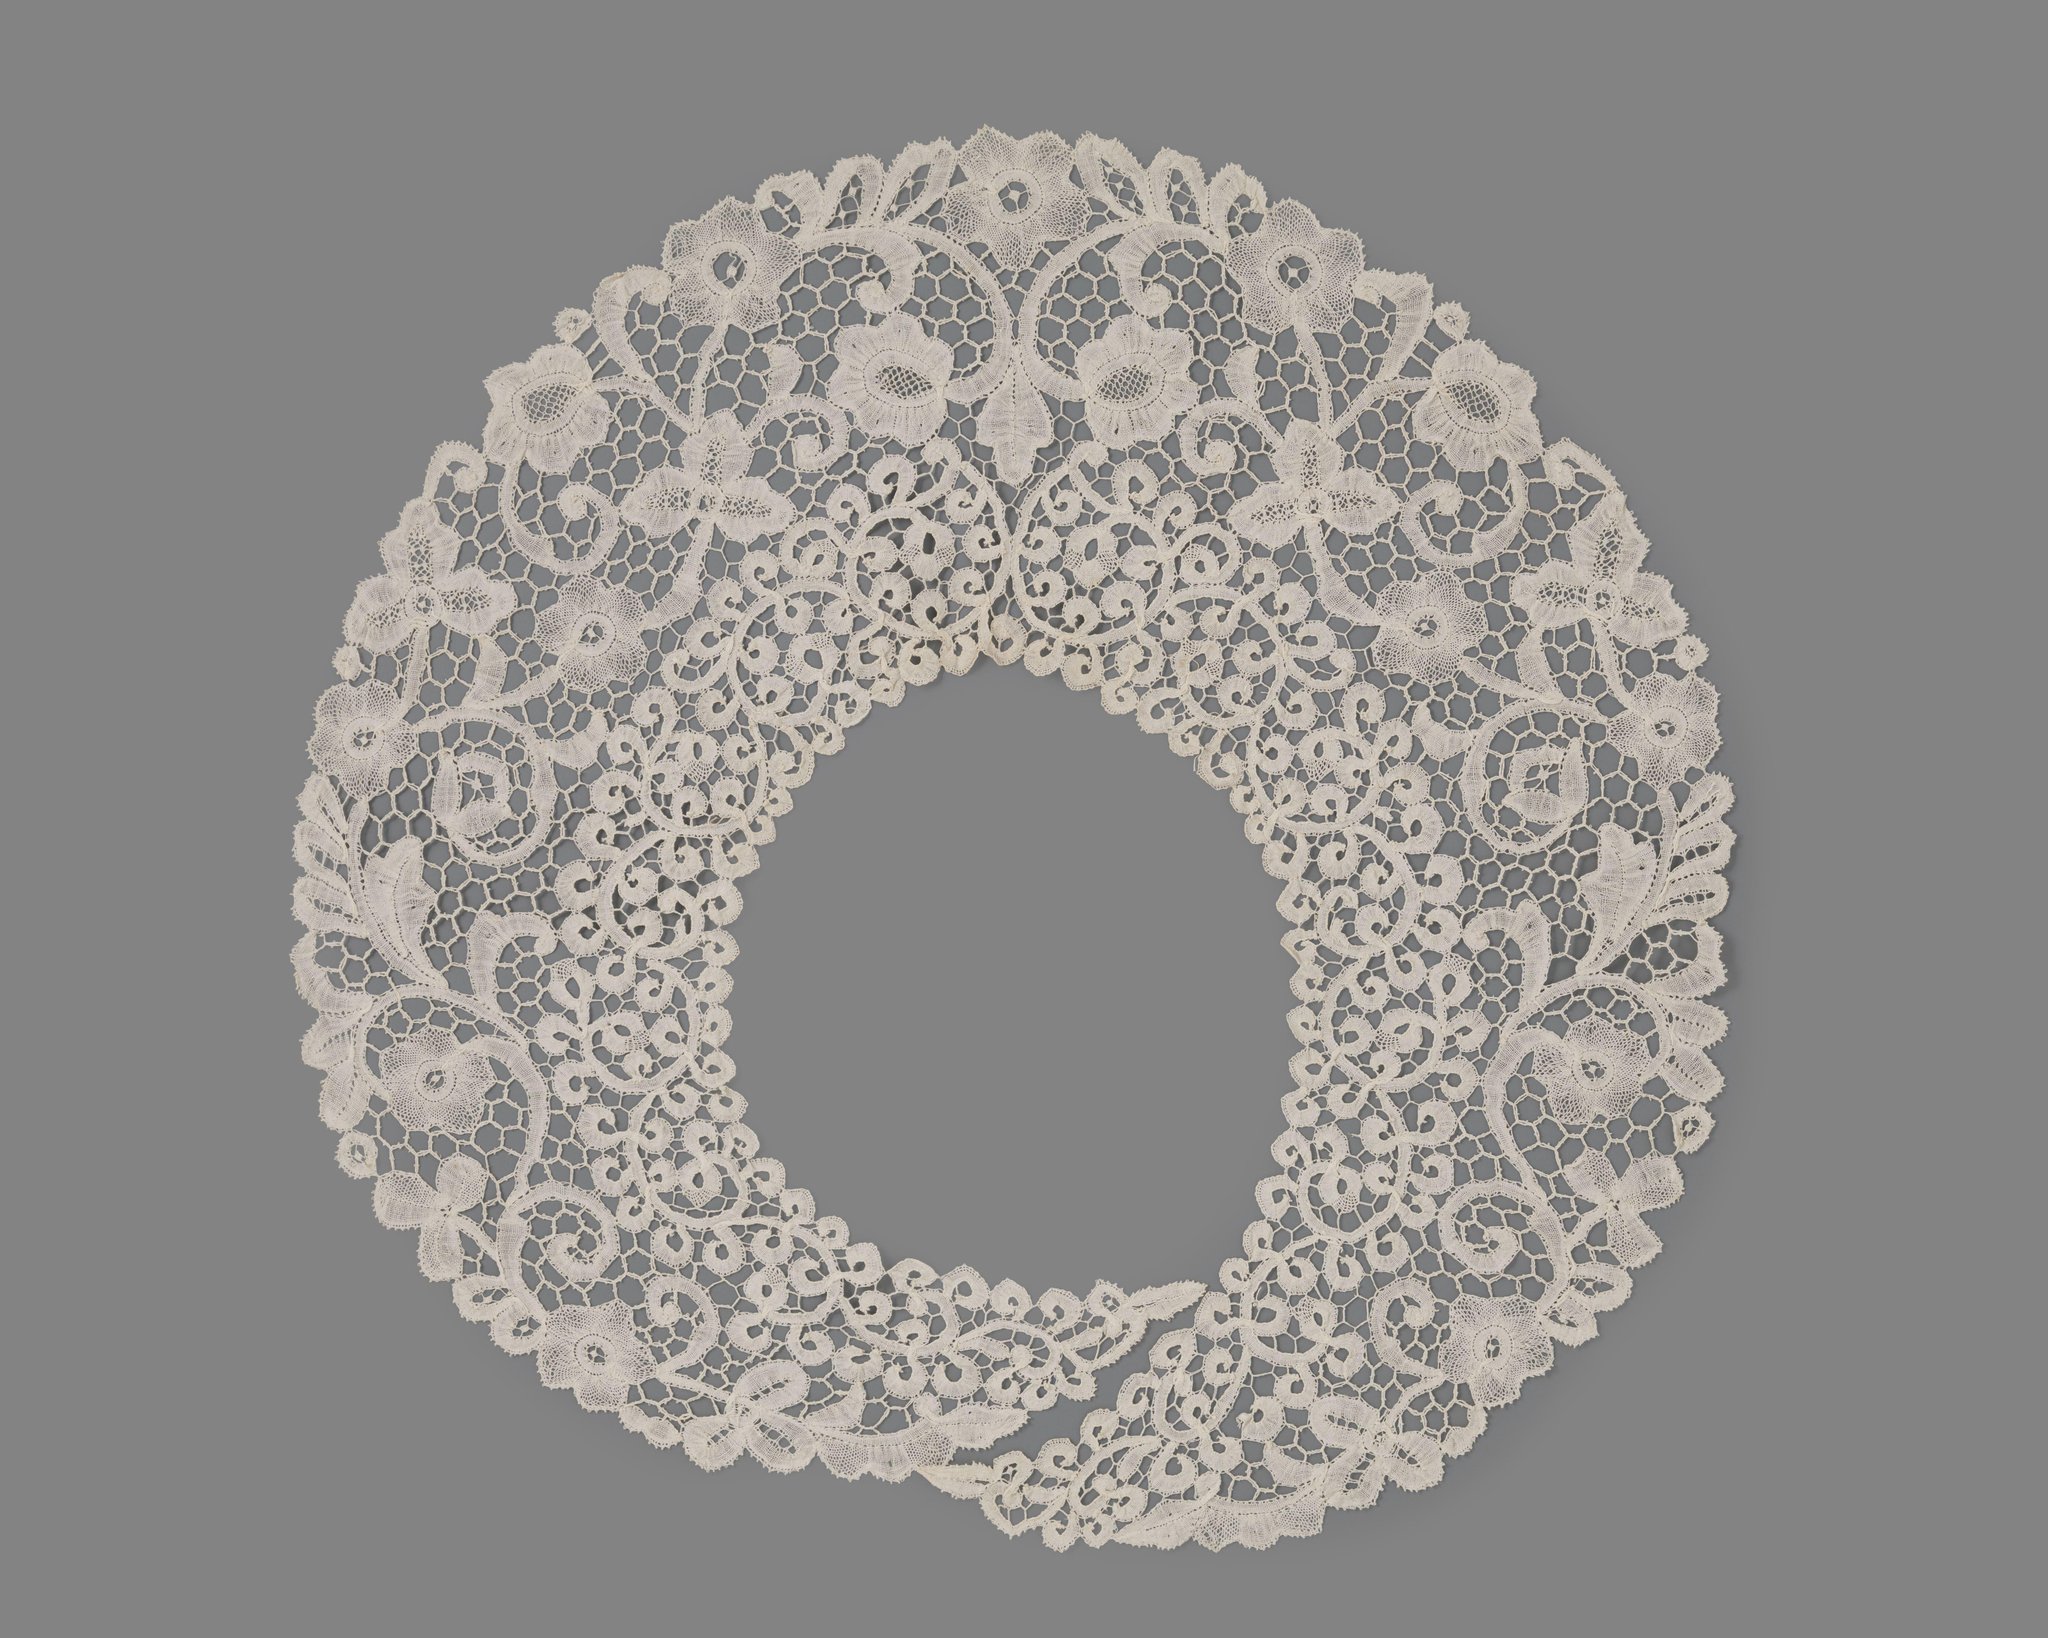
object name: collar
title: Kraag van duchesse met grote bloemenranken en point de Flandre met kleine bloemtakken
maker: maggy rouff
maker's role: modeontwerper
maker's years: 1896-1971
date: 1936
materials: linen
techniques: lace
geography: paris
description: Grote losse kanten kraag, horend bij avondjapon. Combinatie van Duchesse met grote bloemenranken en point de Flandre met kleine bloementakken.